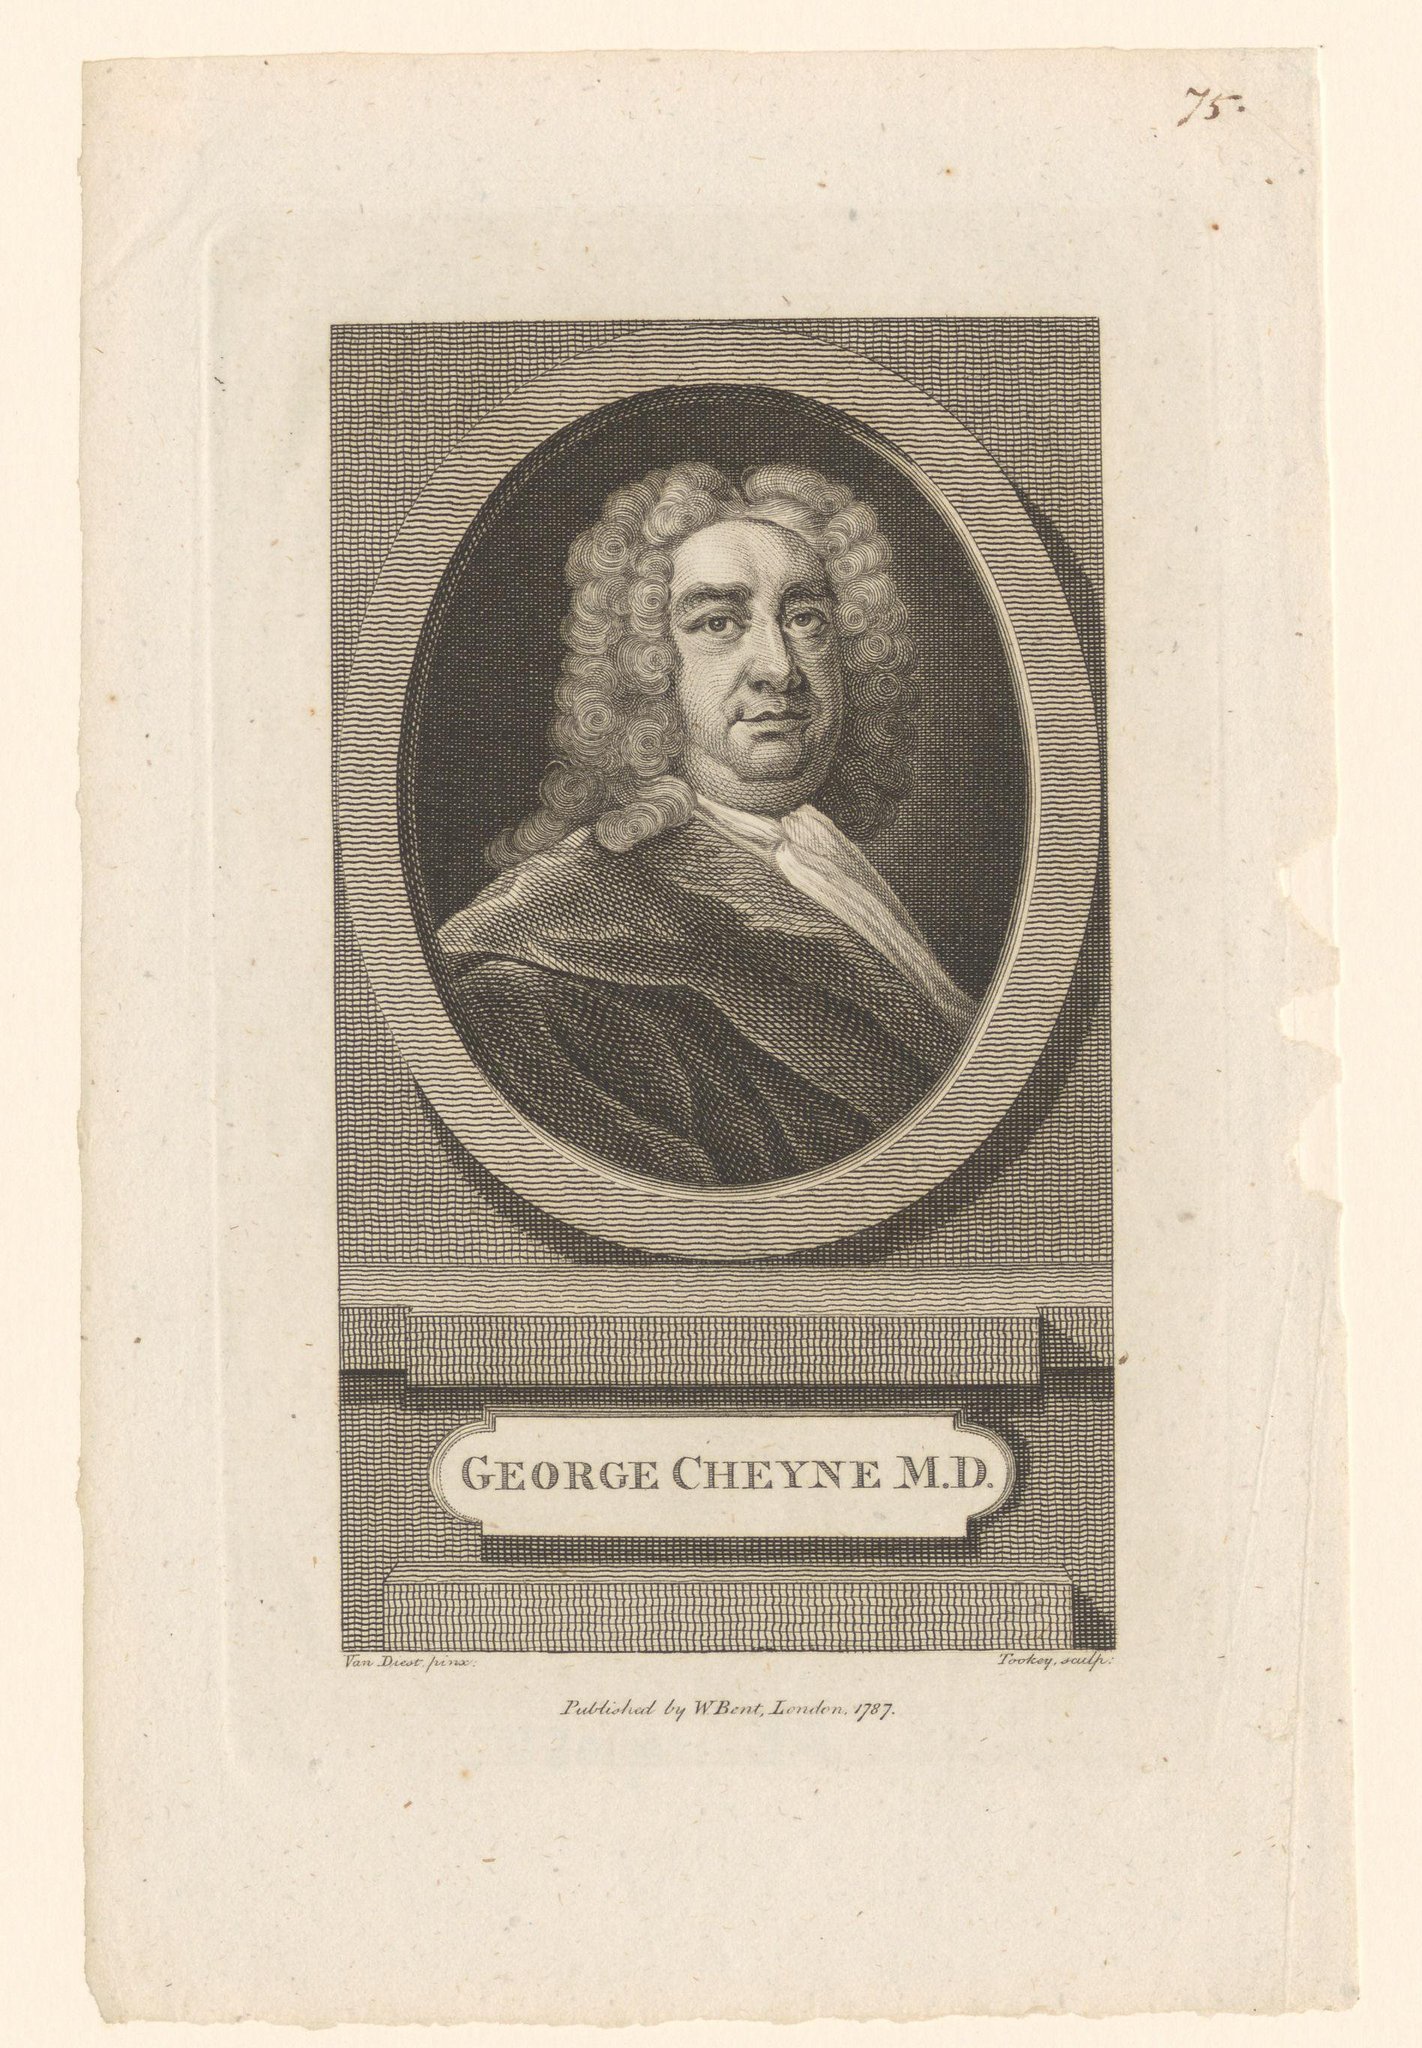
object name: print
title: Portret van George Cheyne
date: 1787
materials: paper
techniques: engraving, etching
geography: london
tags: historical persons, physician, doctor (+ portrait of scholar, scientist)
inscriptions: collector's mark: Lugt 2228